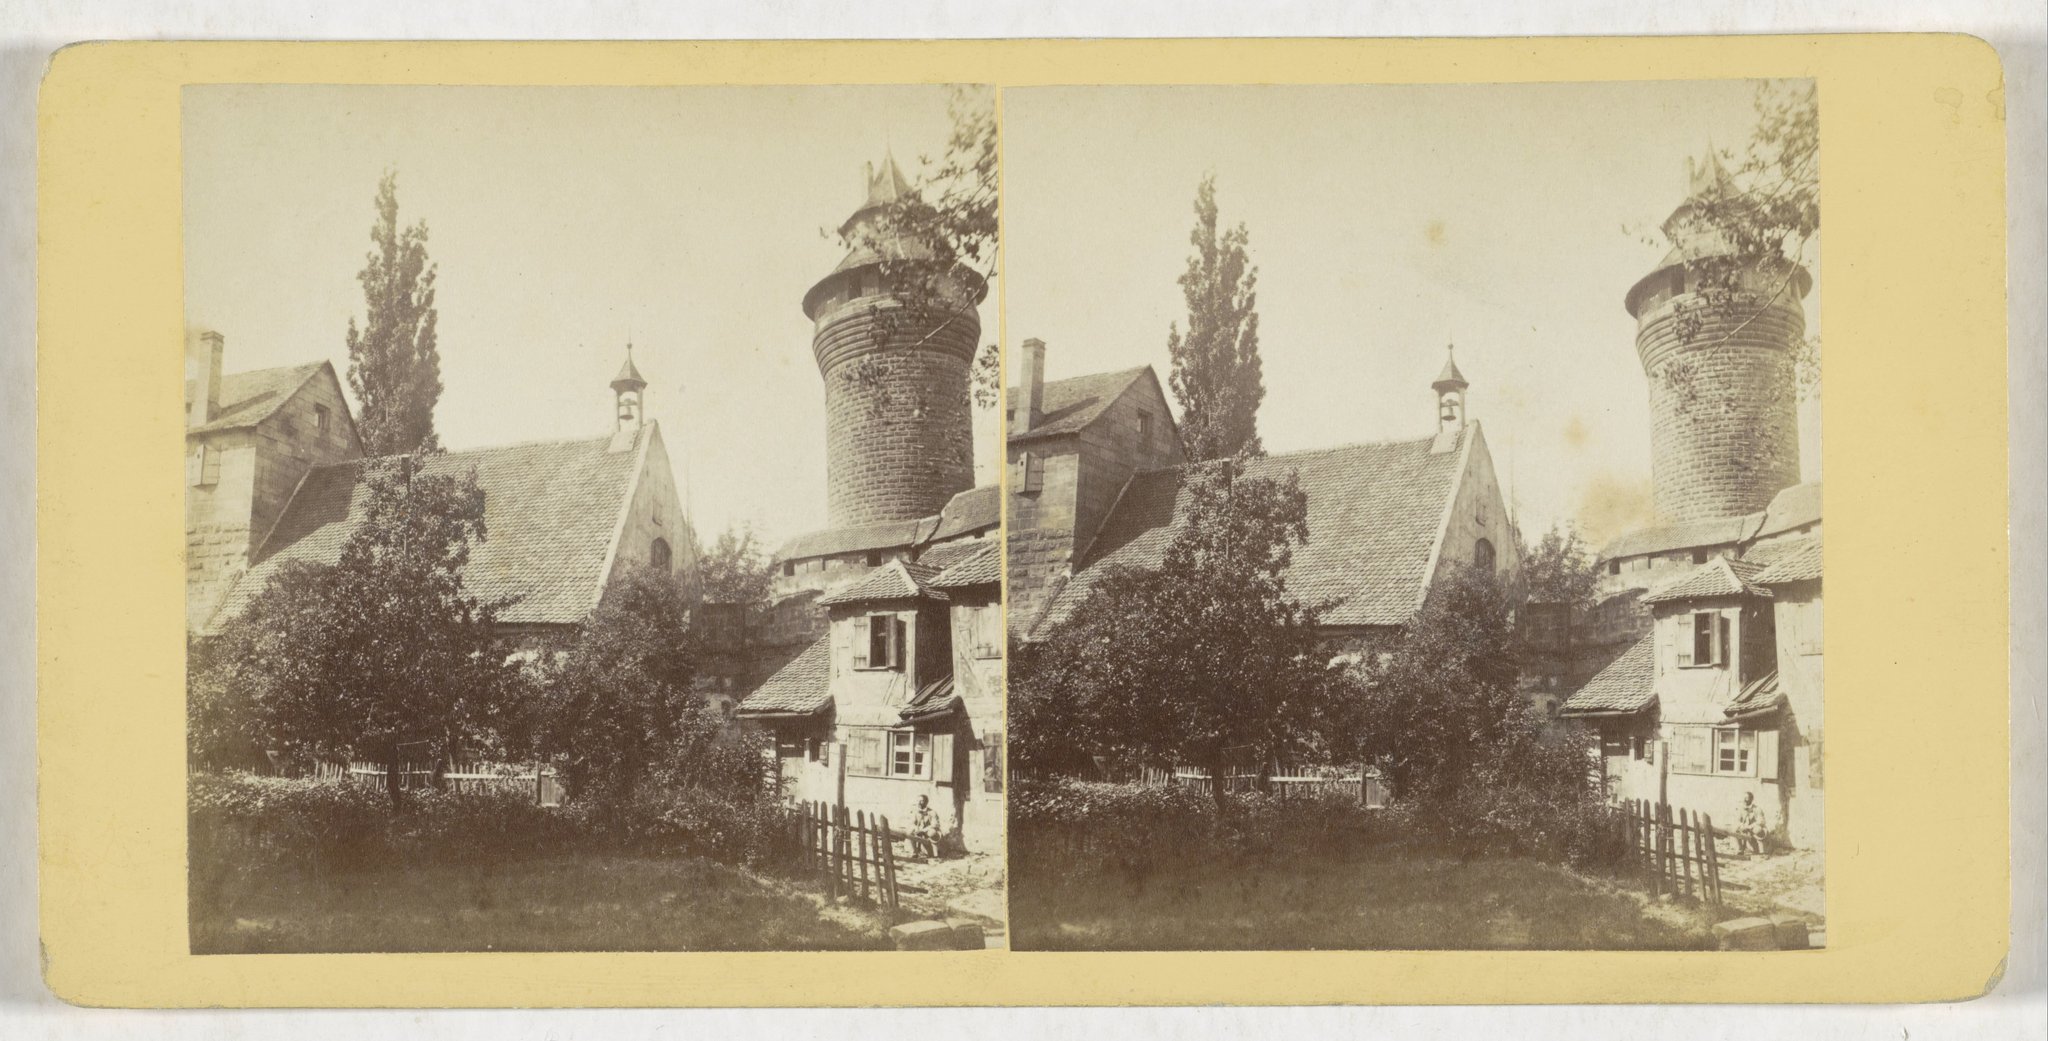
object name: stereograph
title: Nürnberg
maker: johann friedrich stiehm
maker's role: fotograaf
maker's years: 1826-1902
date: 1868-1888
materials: cardboard, paper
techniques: albumen print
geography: london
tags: parts of church exterior and annexes: chapel - qq - small church, chapel, tower (of house or building)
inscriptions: number: ‘No. 20.’